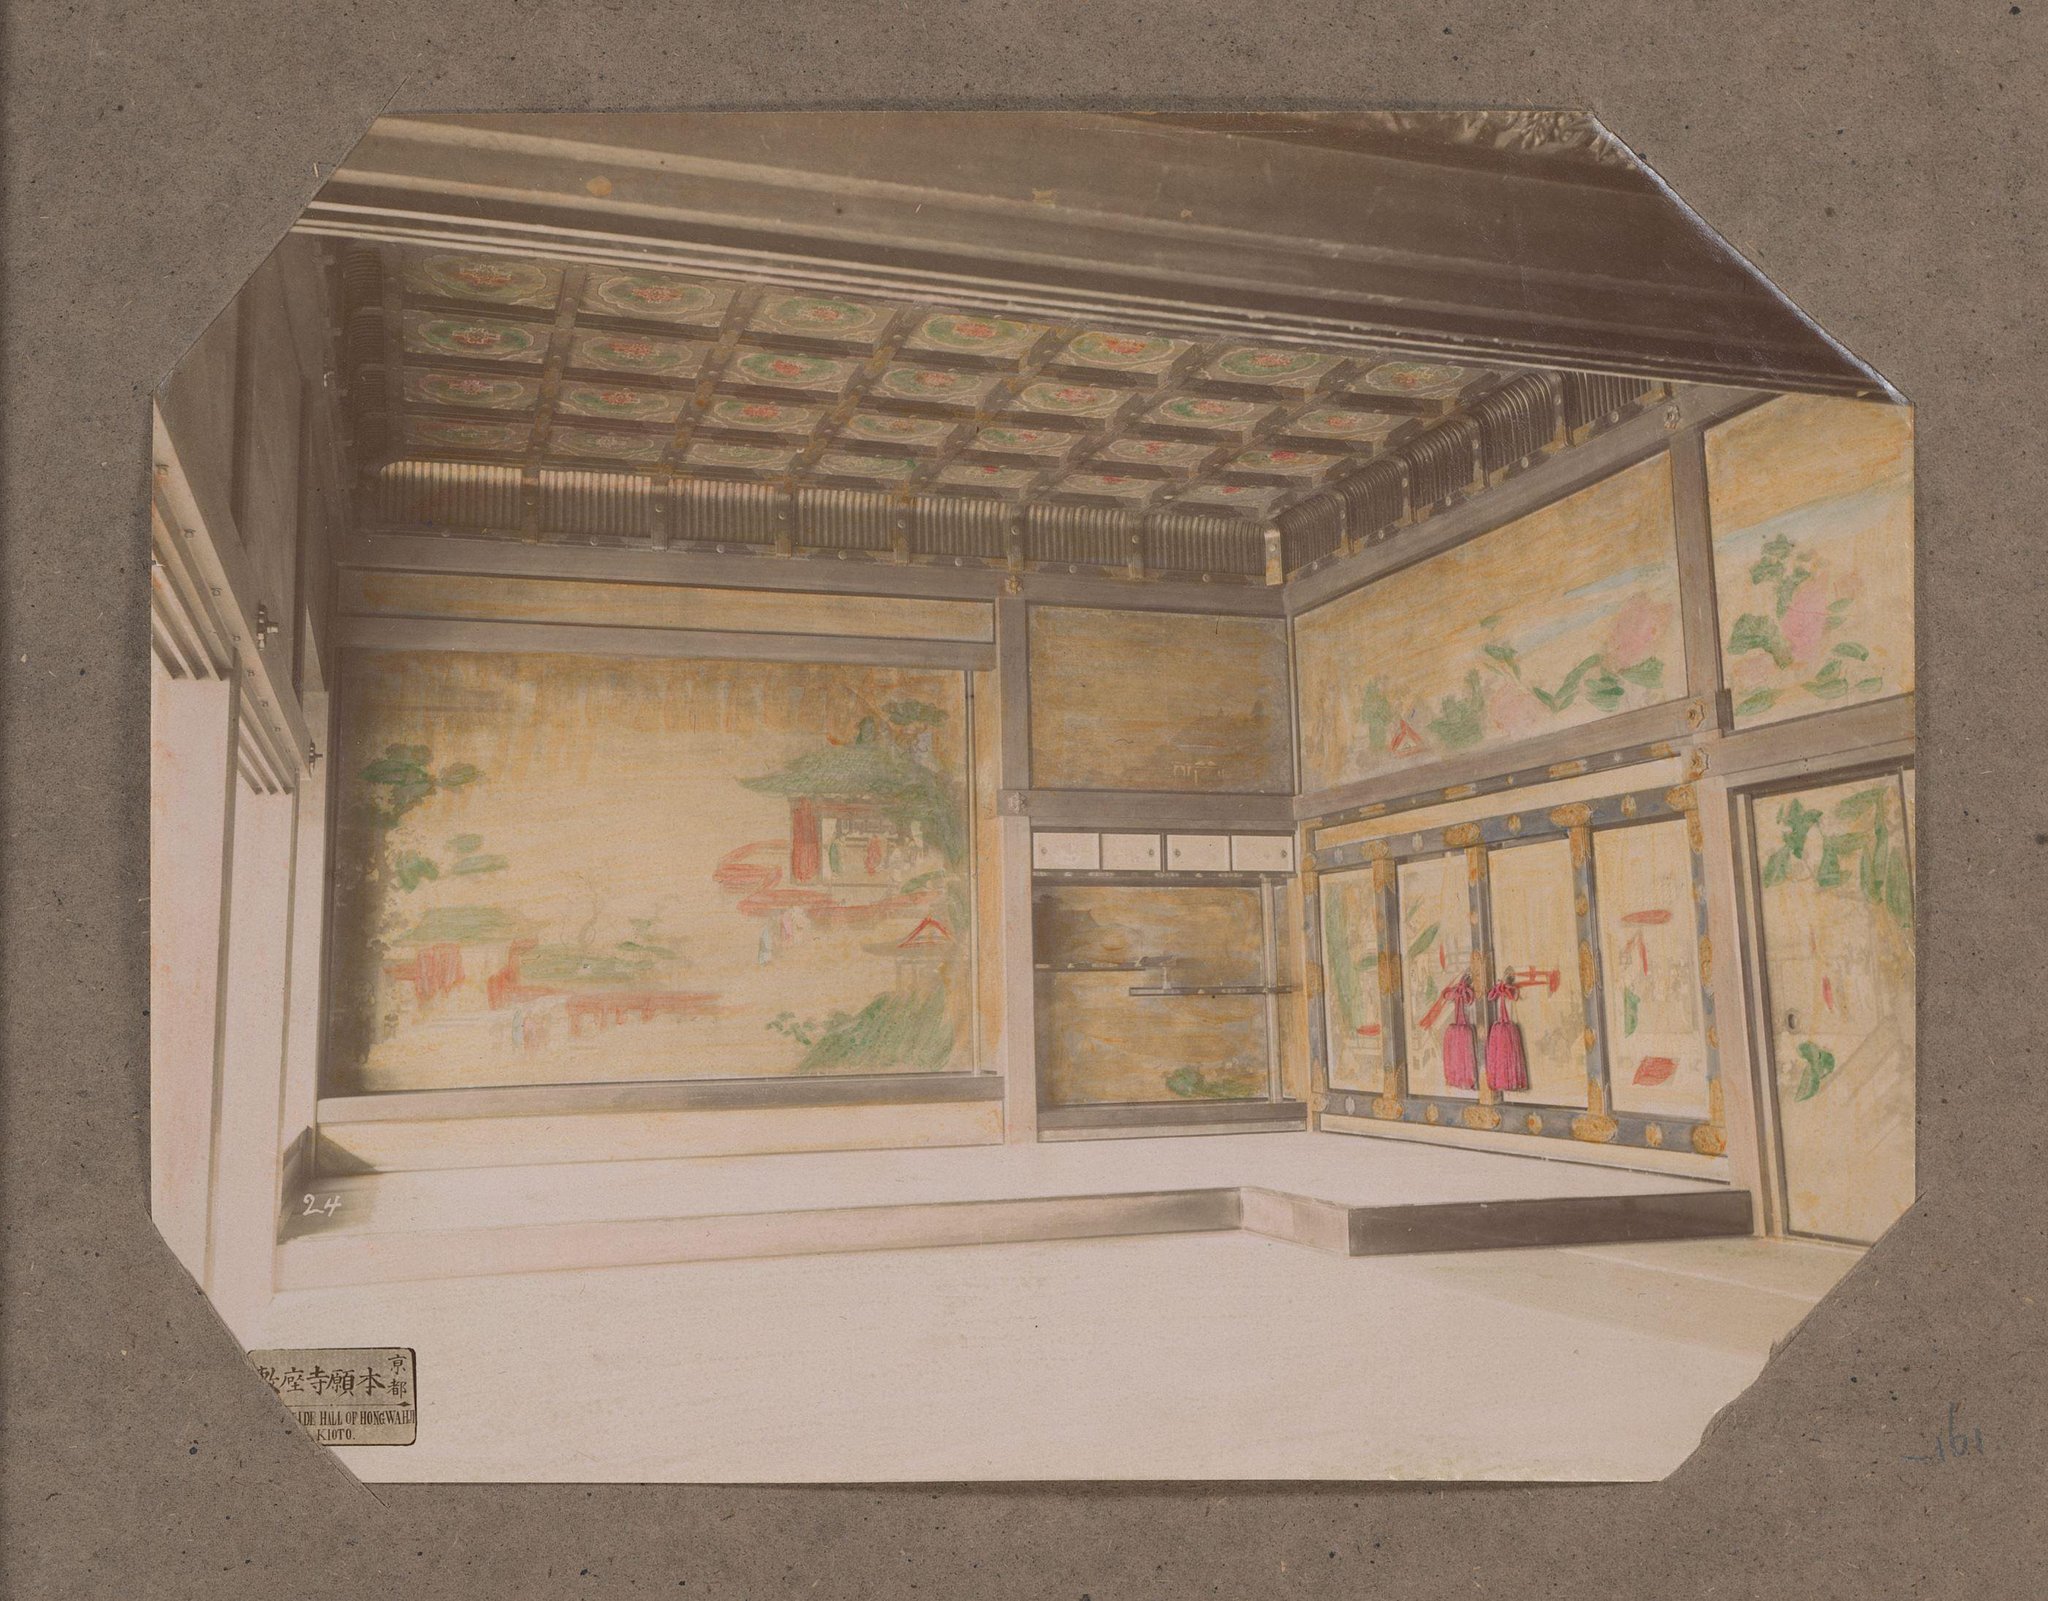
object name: photograph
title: Interieur van een ruimte in de Nishi Hongan-ji tempel in Kyoto, Japan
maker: Anonymous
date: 1890-1903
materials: paper, photographic support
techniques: albumen print, hand coloring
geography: kyoto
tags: temple, shrine ~ hinduism, buddhism, jainism, interior of the house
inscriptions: inscription: ‘24 /The inside Hall of Hongwahji /Kioto’